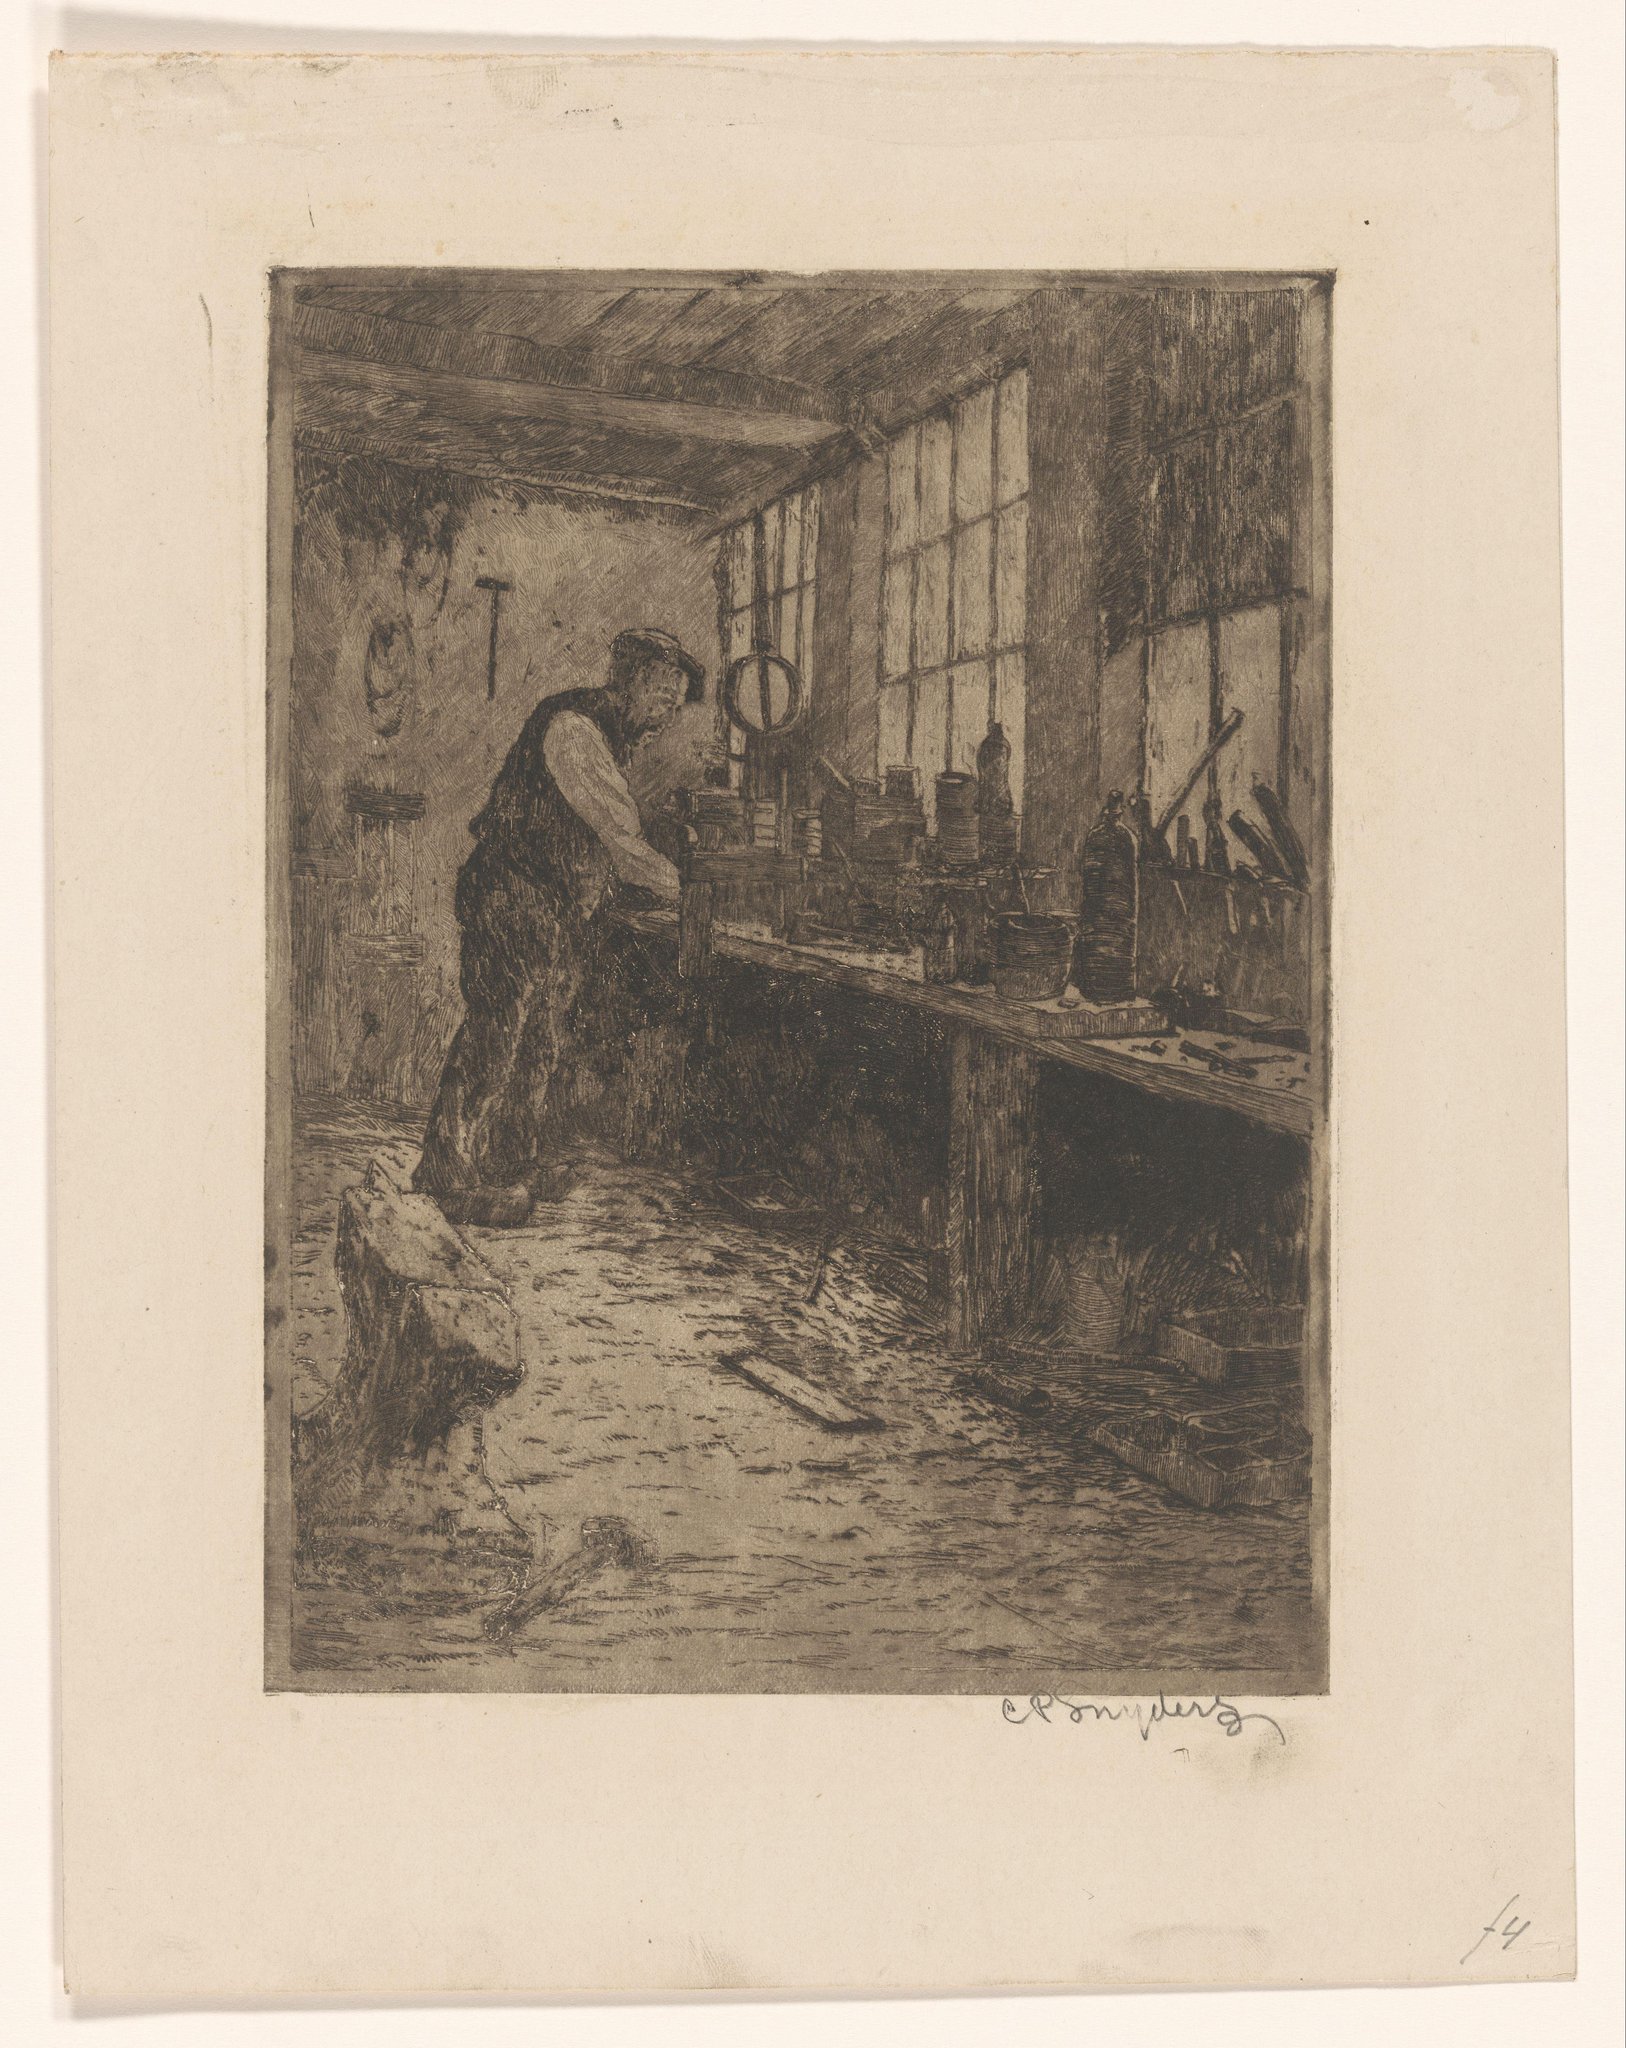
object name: print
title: Man in werkplaats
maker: chris snijders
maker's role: print maker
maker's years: 1881-1943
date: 1891-1943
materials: paper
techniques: etching, intaglio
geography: netherlands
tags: workshop-interior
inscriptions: collector's mark: Lugt 2760, collector's mark: Lugt 2228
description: Een man staat aan de werkbank in een werkplaats. Links staat een aambeeld.